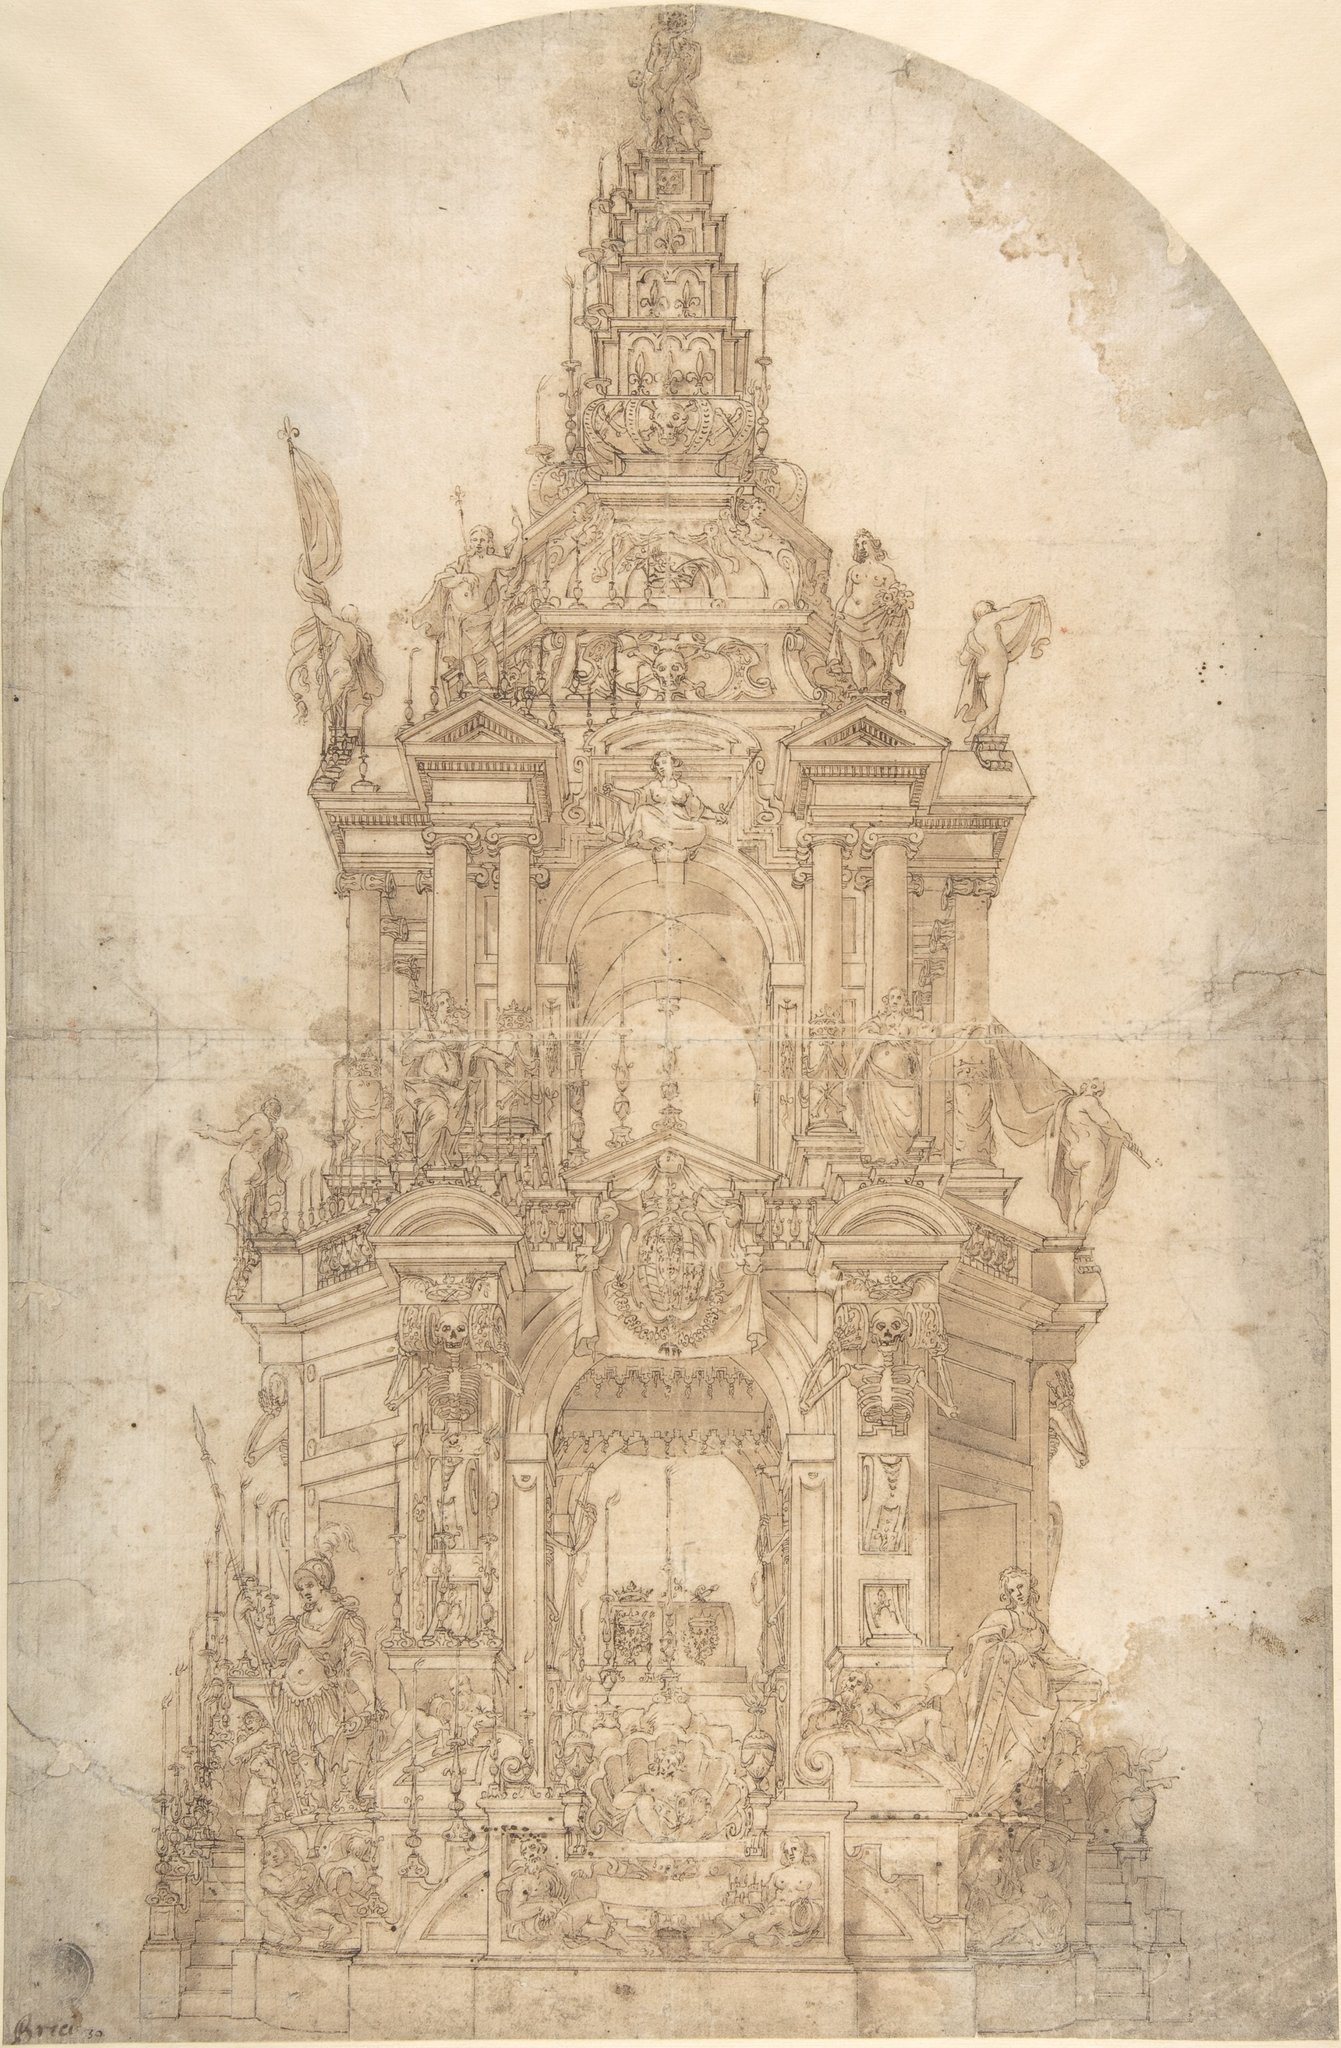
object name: drawing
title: Design for the Catafalque of a Prince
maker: pier francesco battistelli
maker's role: artist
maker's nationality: italian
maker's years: 1610-1625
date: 1610-1625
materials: chalk, ink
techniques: brush, incising, pen, wash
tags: tombs